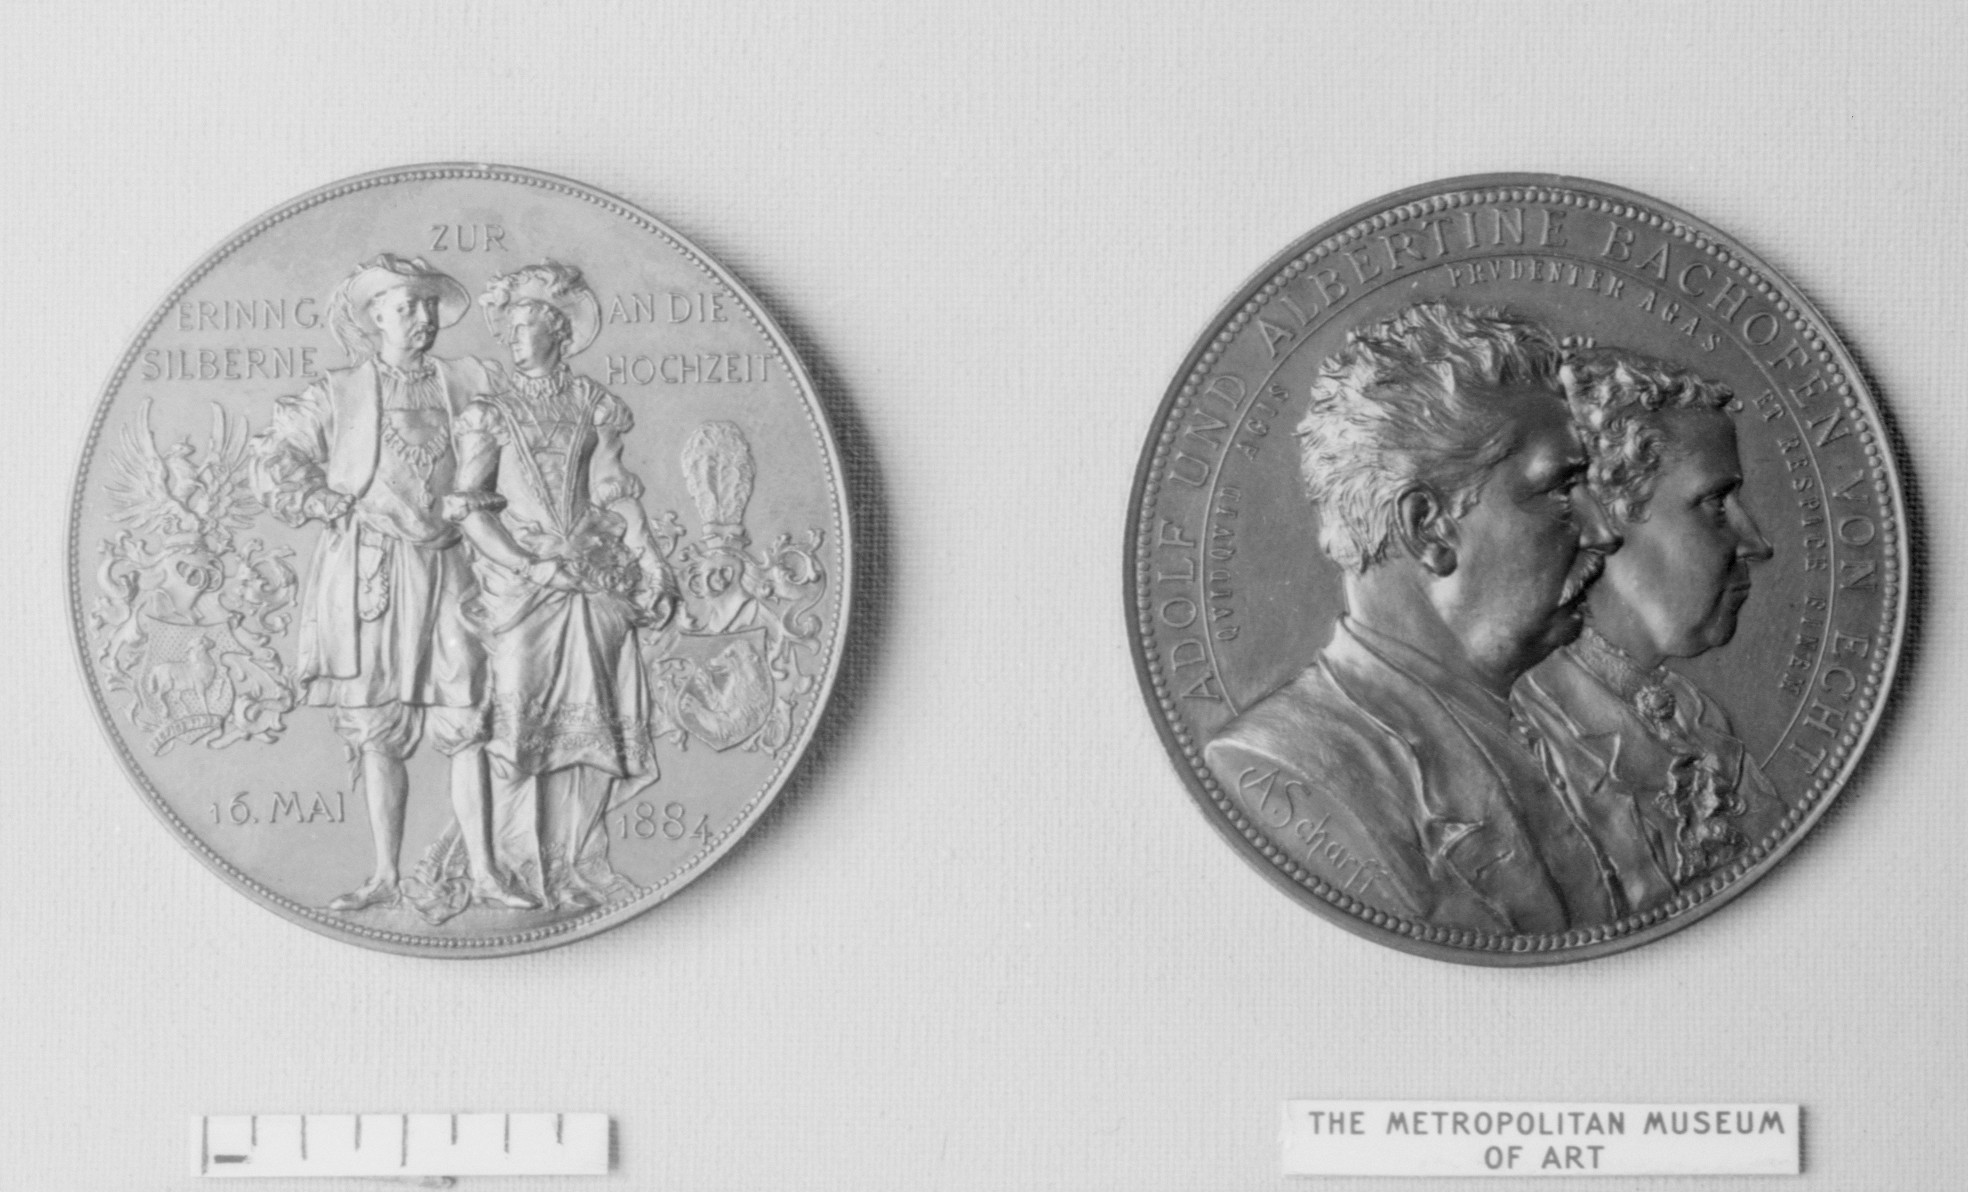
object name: medal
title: To Commemorate the Silver Wedding of Adolf and Albertine Bachofen von Echt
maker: anton scharff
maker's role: artist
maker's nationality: austrian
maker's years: 1845-1903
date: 1884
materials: bronze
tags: men,profiles,women